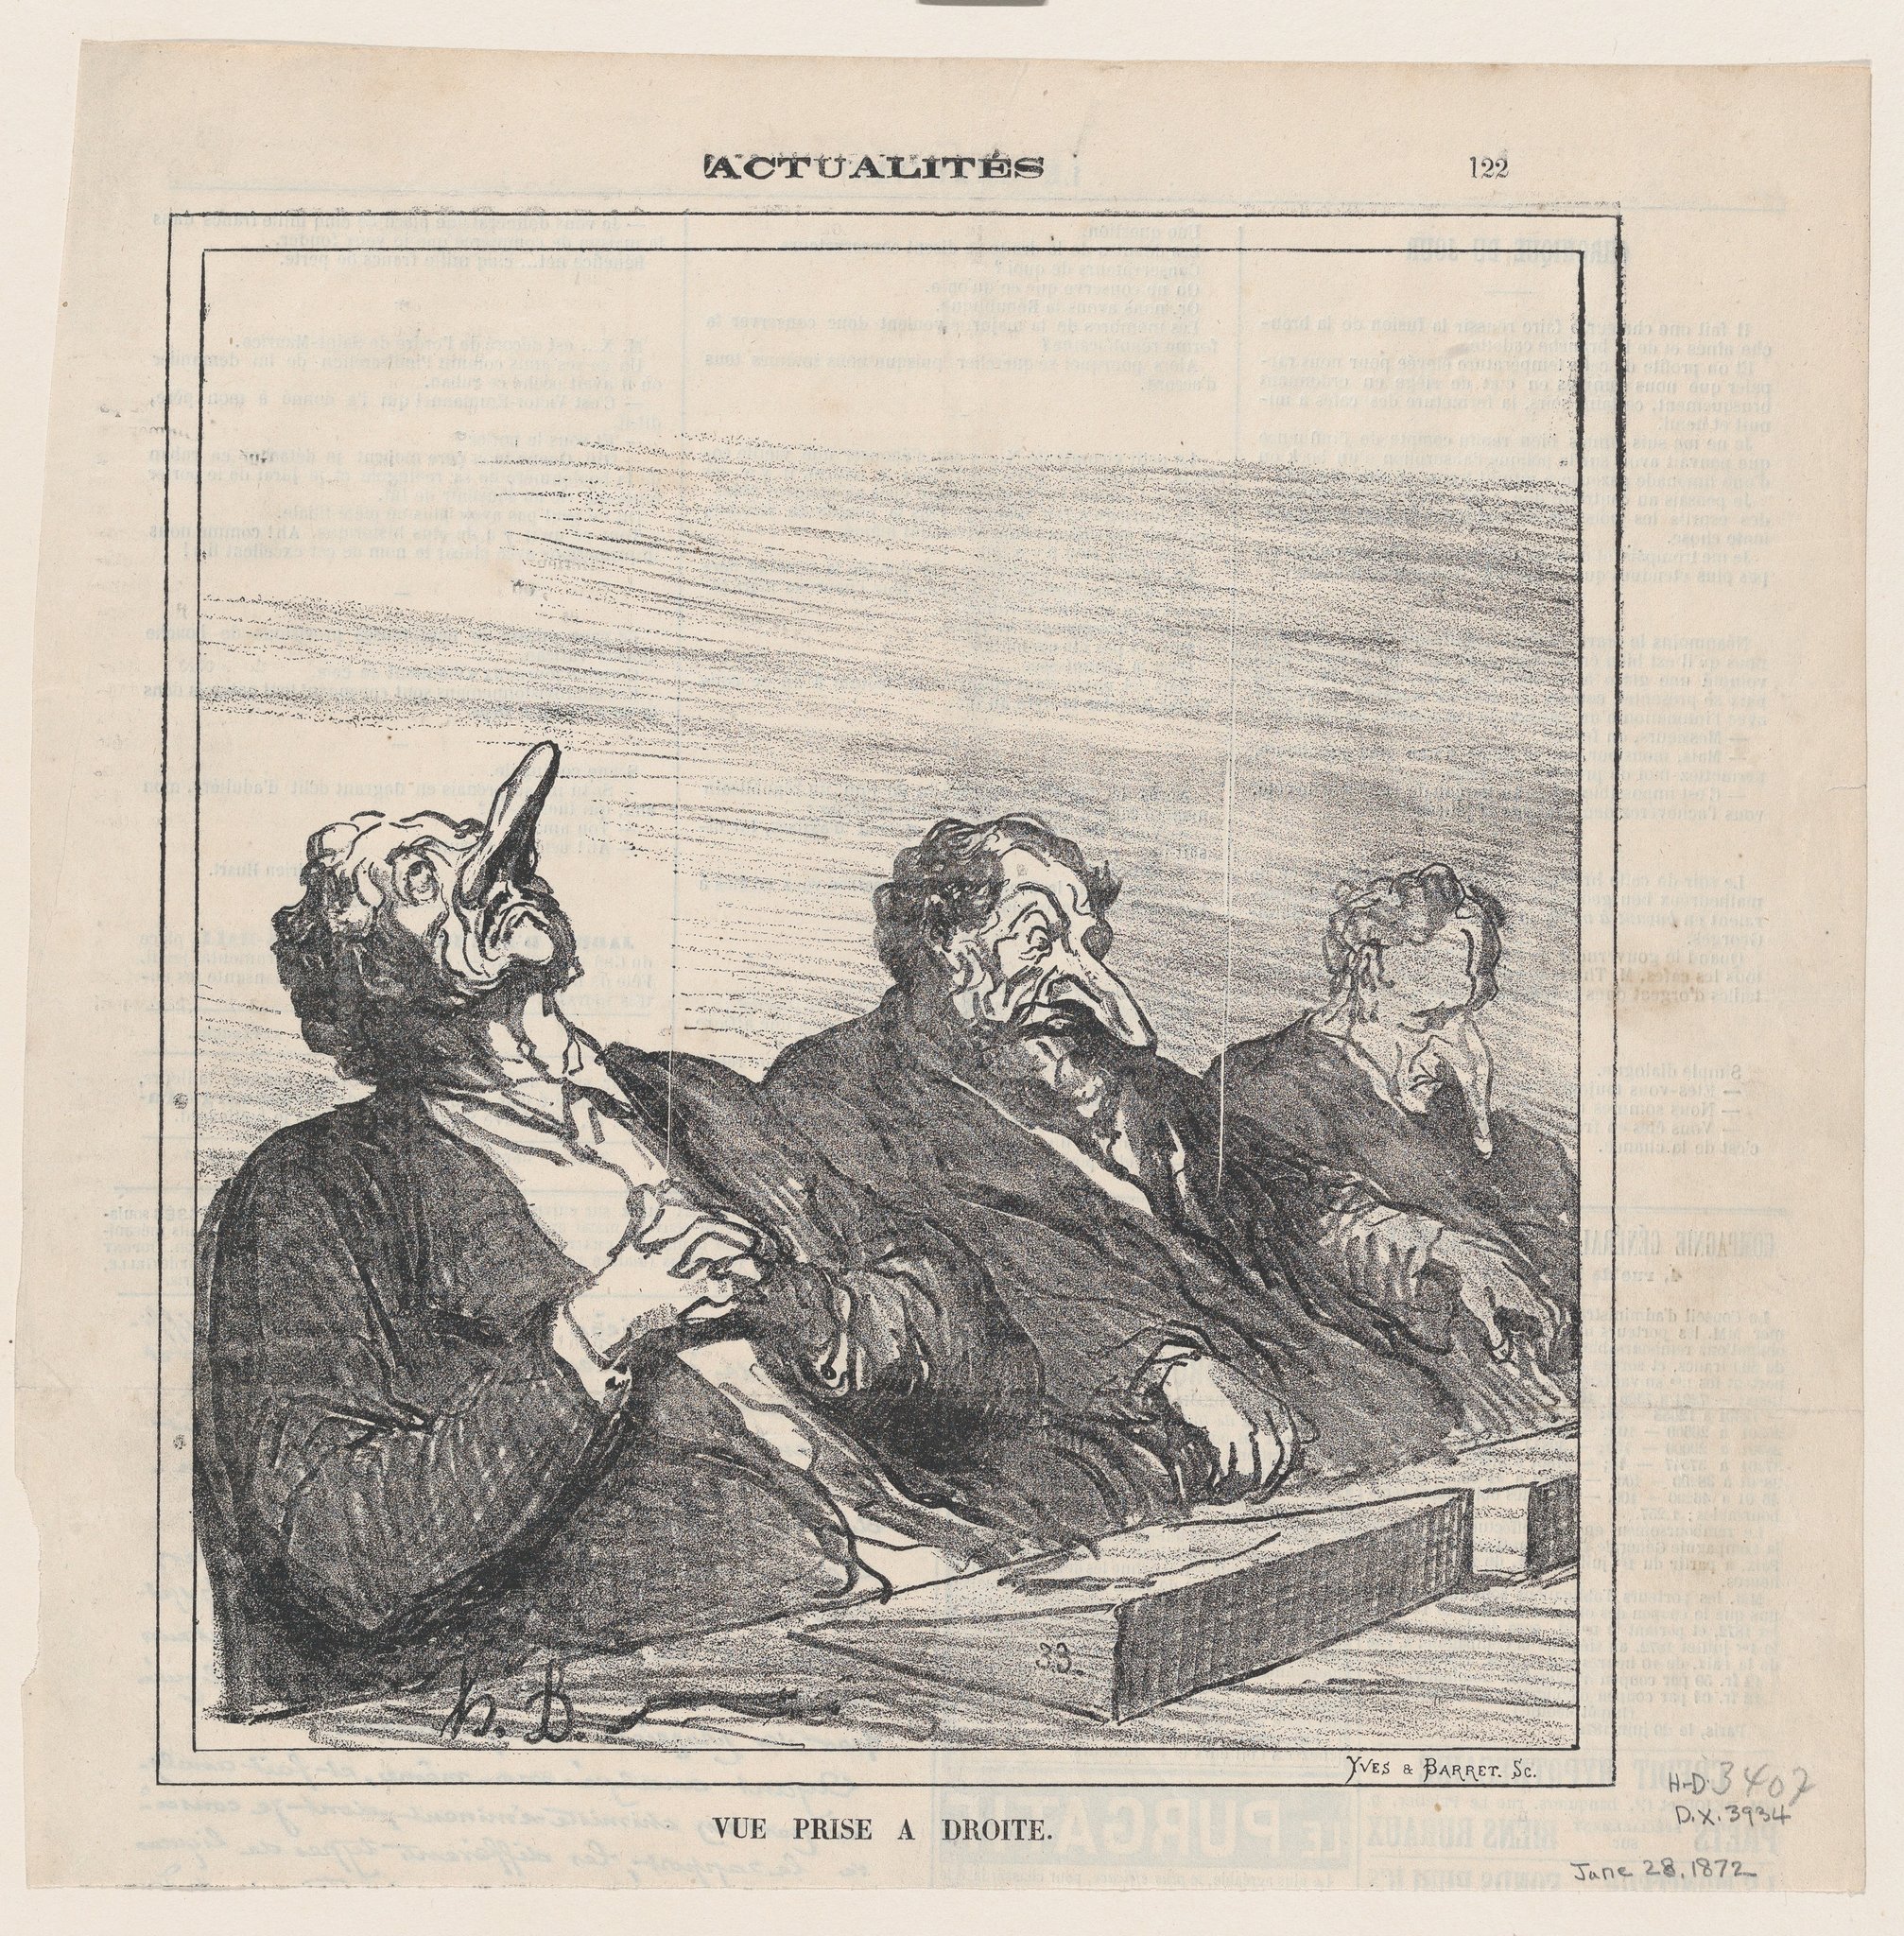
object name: print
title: View of the right, from 'News of the day,' published in Le Charivari, June 28, 1872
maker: honoré daumier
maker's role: artist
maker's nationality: french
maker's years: 1808-1879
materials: paper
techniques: lithograph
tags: satire,men